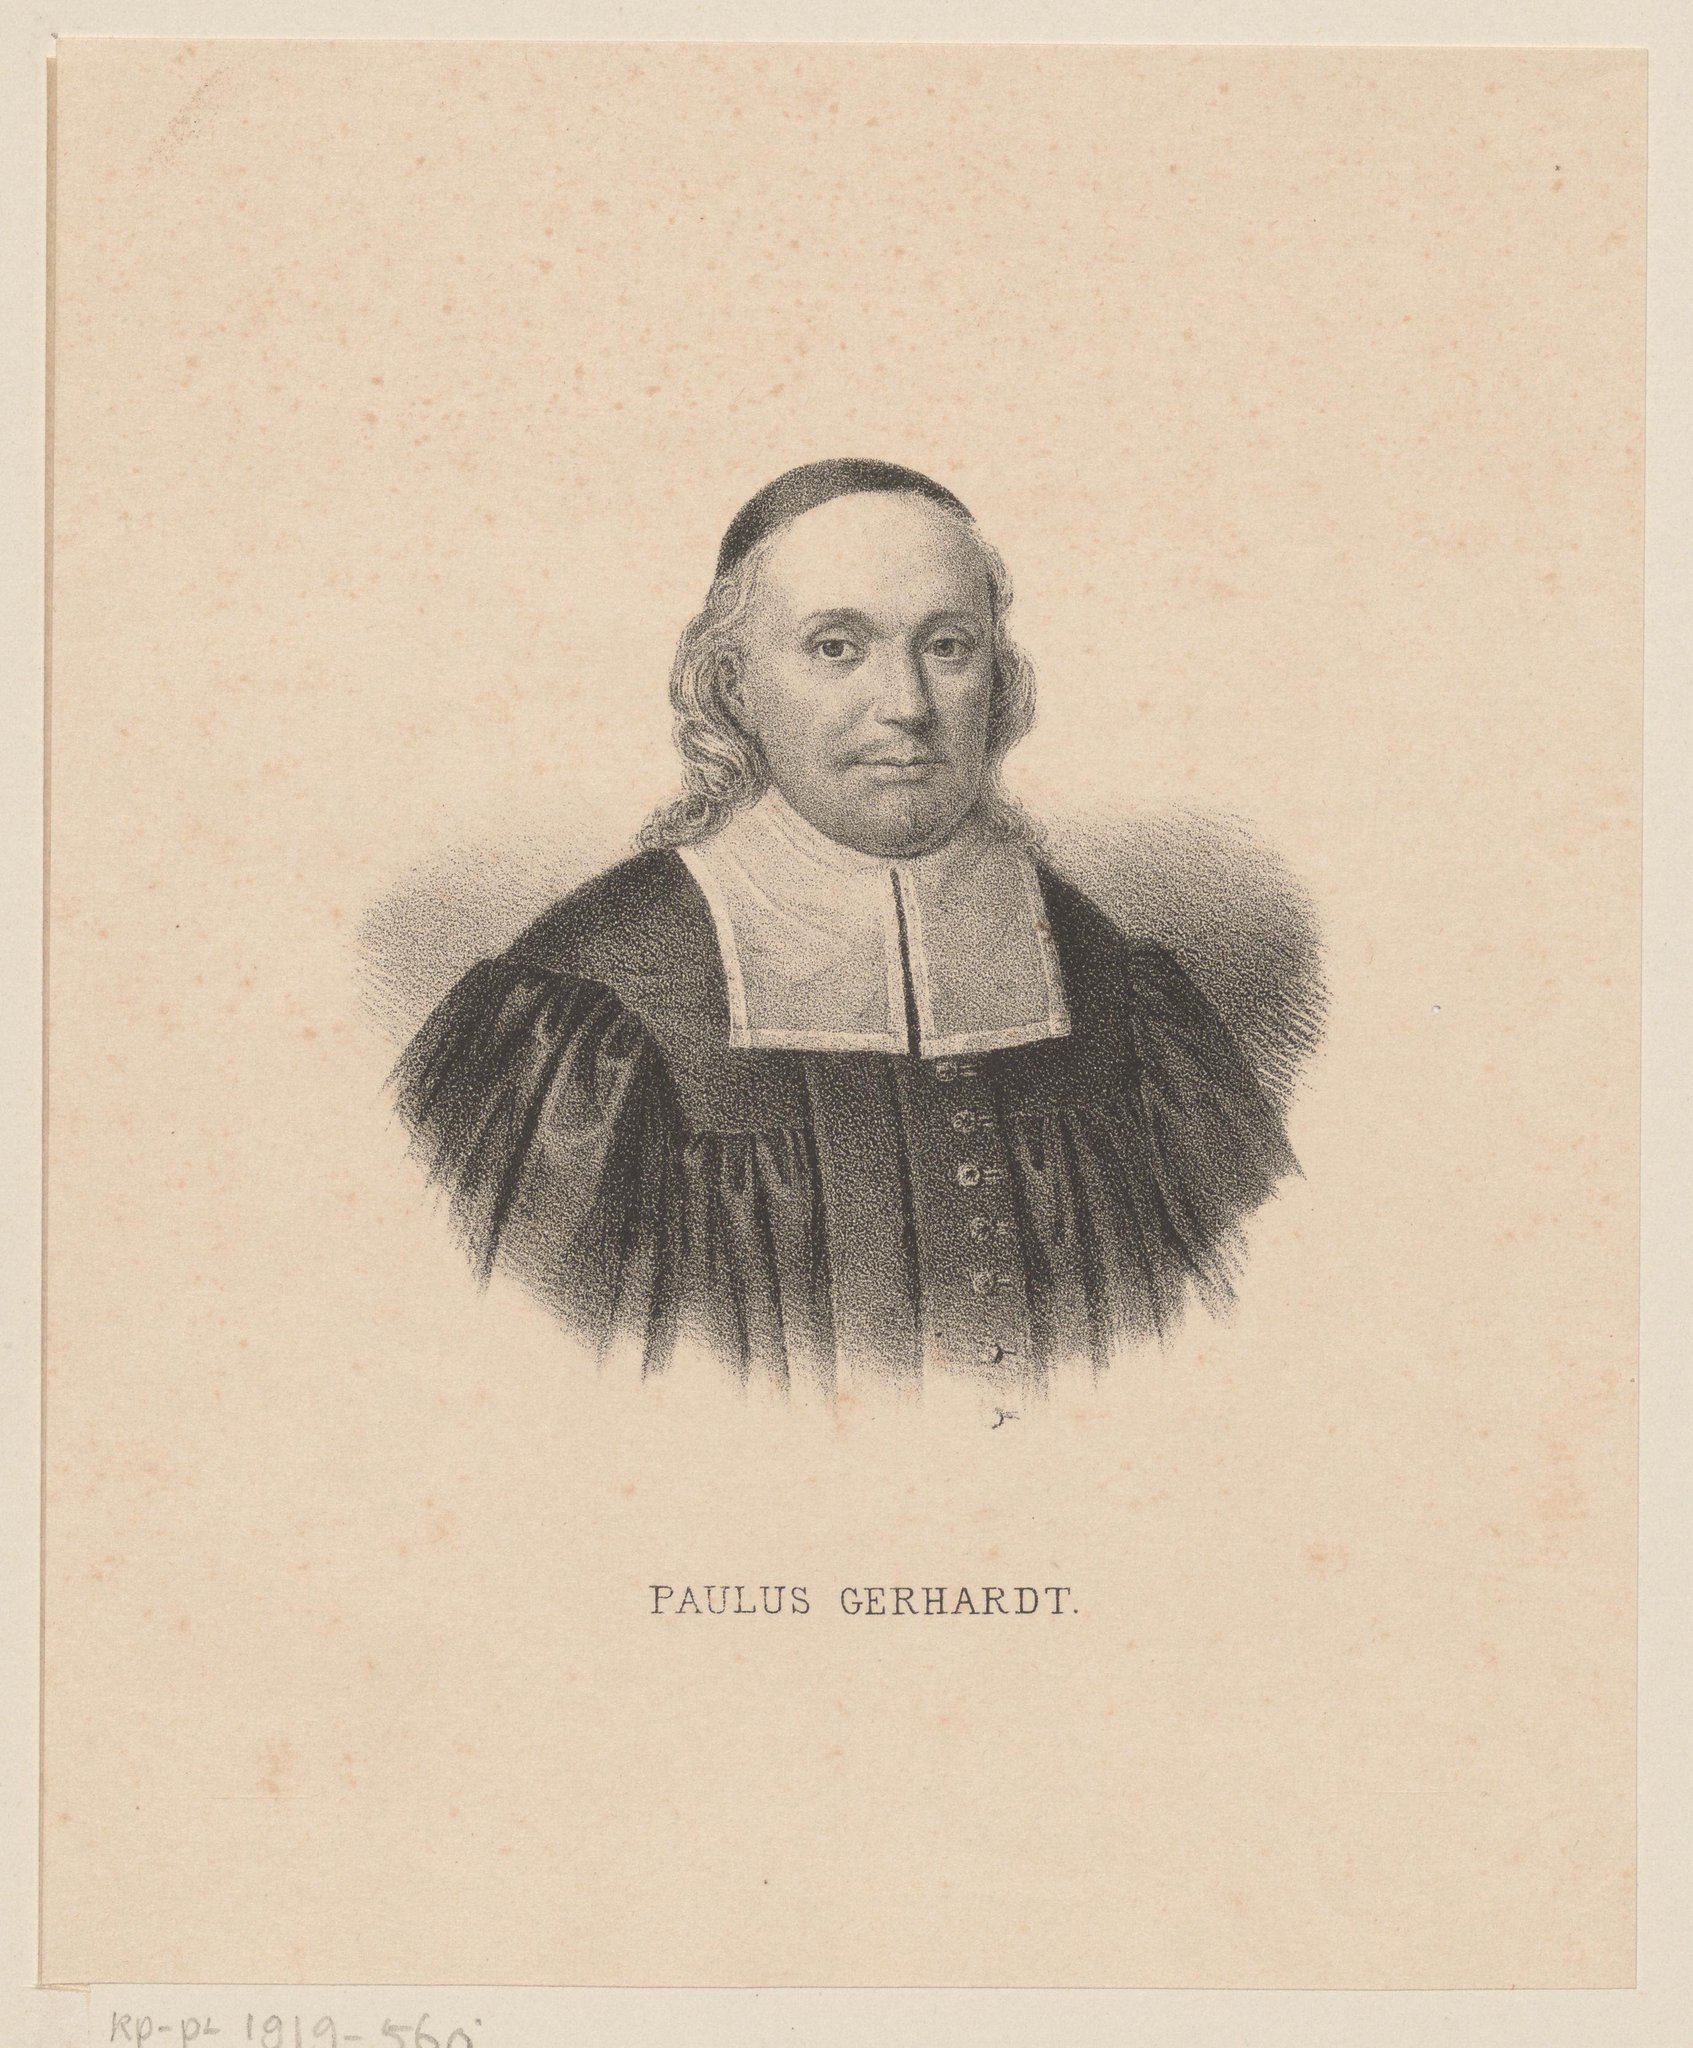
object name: print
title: Portret van Paul Gerhardt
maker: Anonymous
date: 1800-1900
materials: paper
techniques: lithograph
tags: historical persons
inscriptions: collector's mark: Lugt 2228